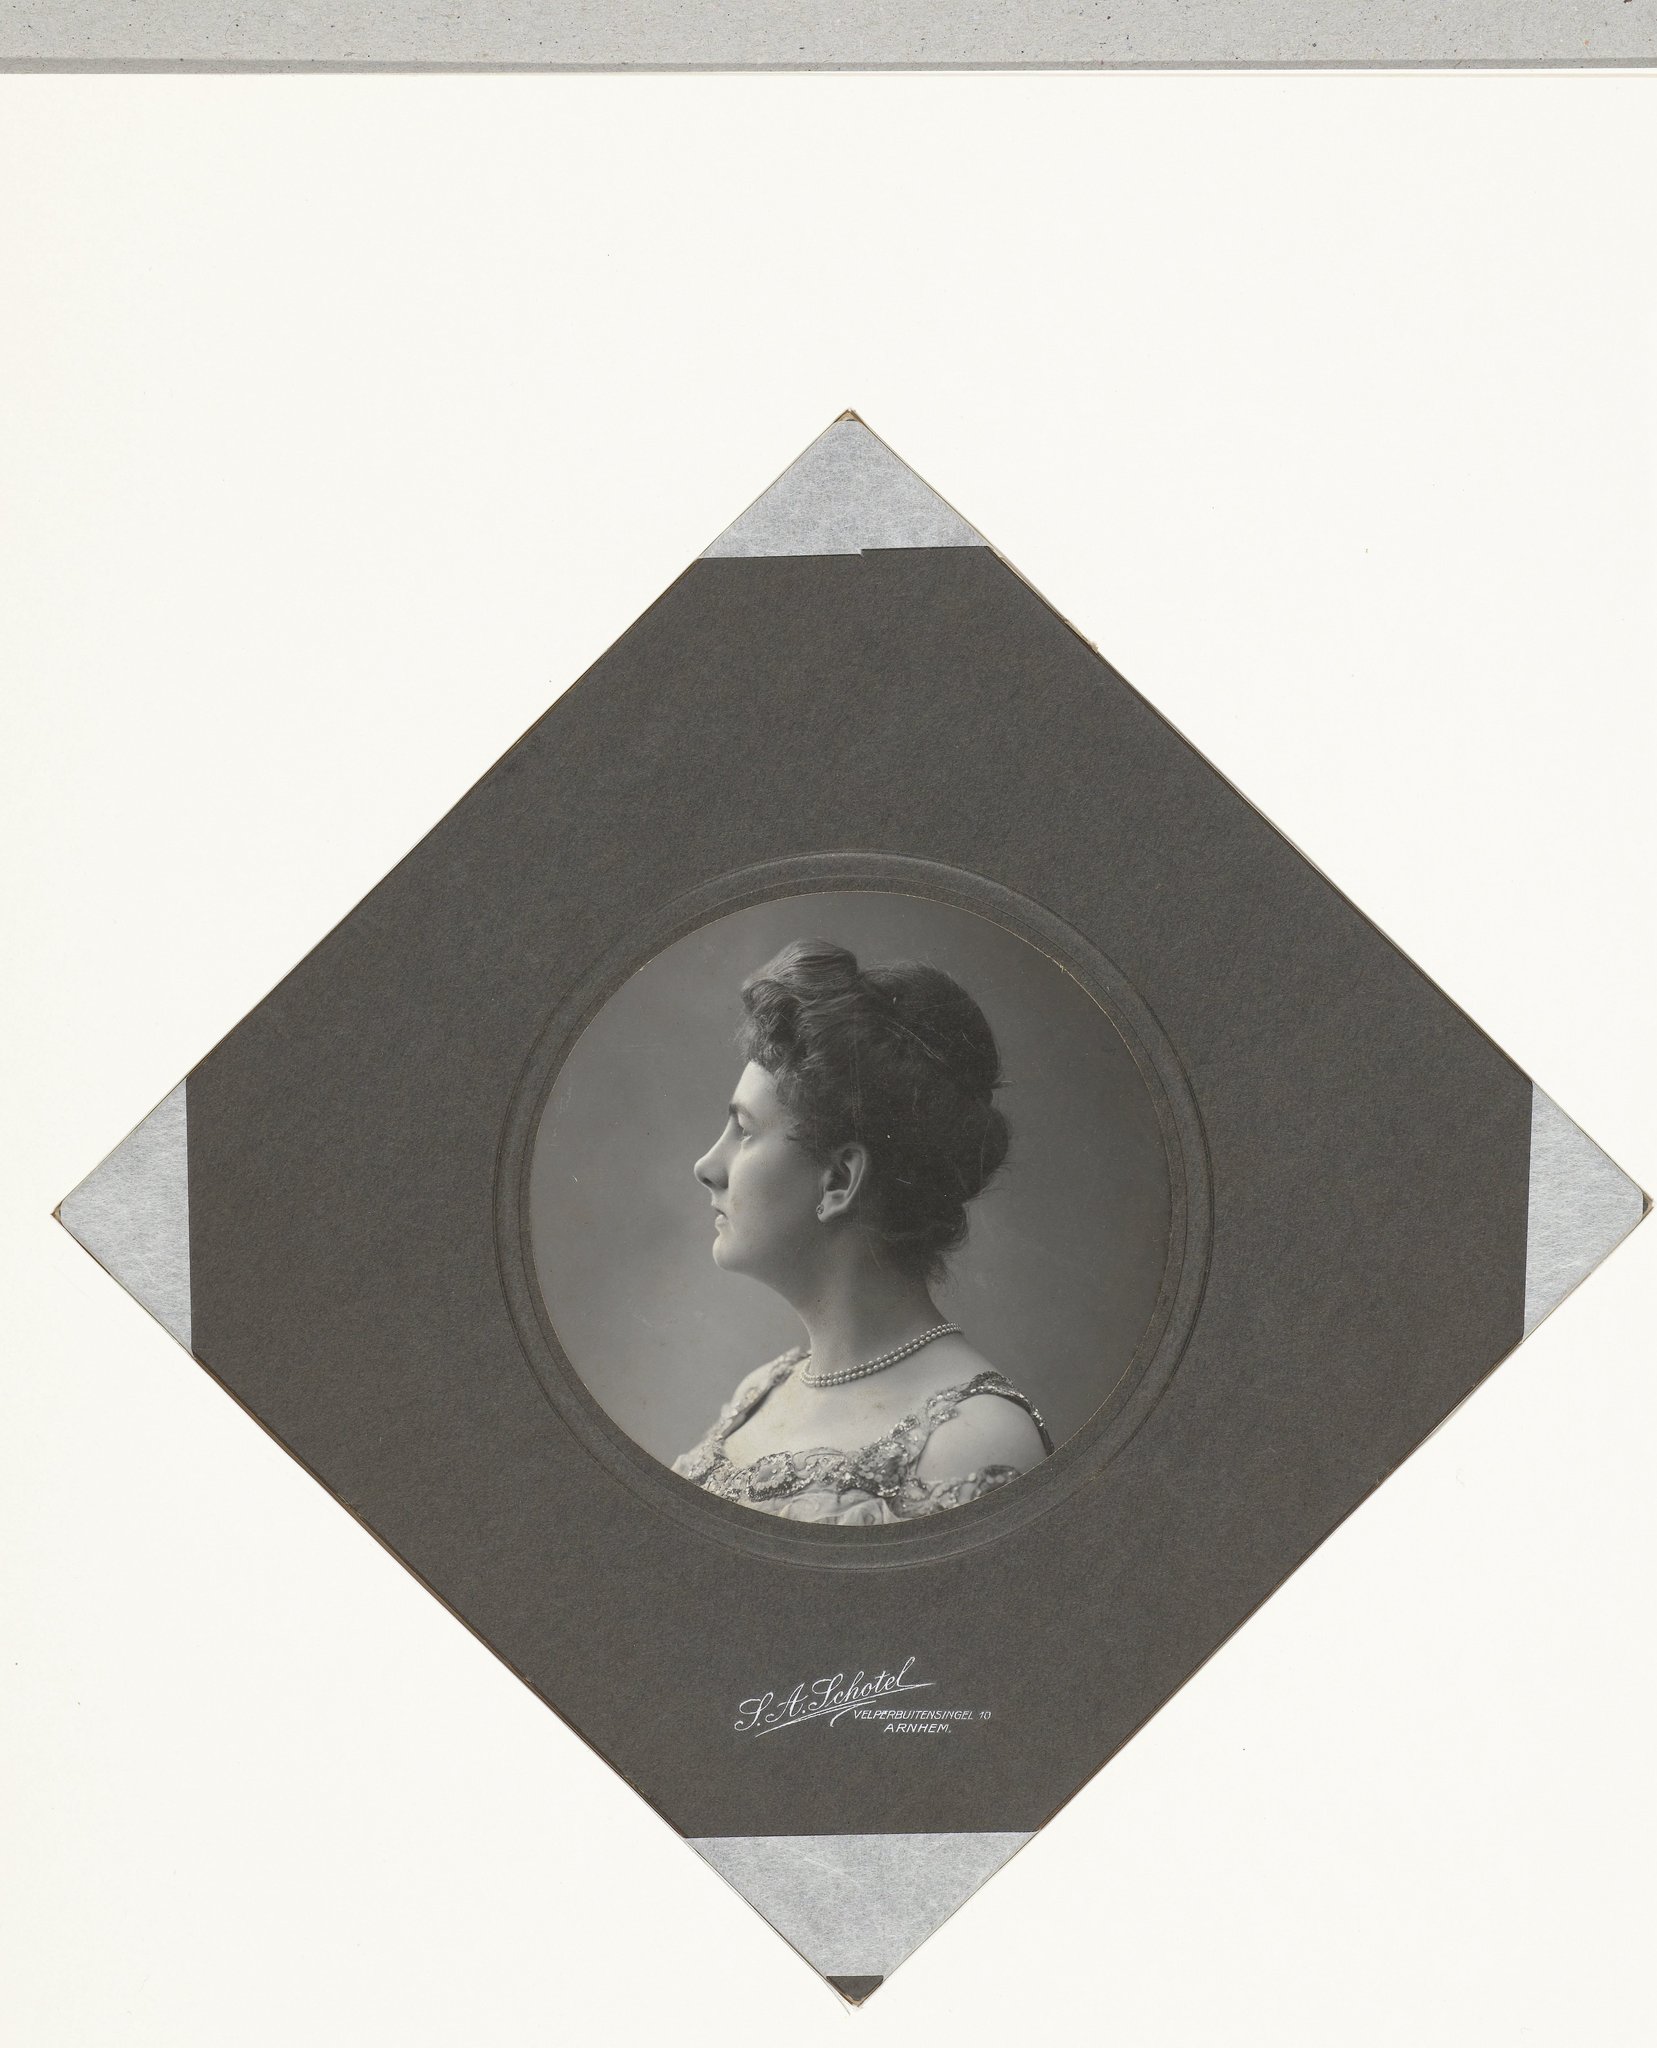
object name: photograph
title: Ida v. Braam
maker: stephanus adrianus schotel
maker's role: fotograaf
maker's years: 1871-1957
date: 1900-1940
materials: cardboard, paper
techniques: matte daylight collodion silver print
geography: arnhem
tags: historical persons - bb - woman, netherlands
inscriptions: name: ‘S.A. Schotel, Velperbuitensingel 10 Arnhem’